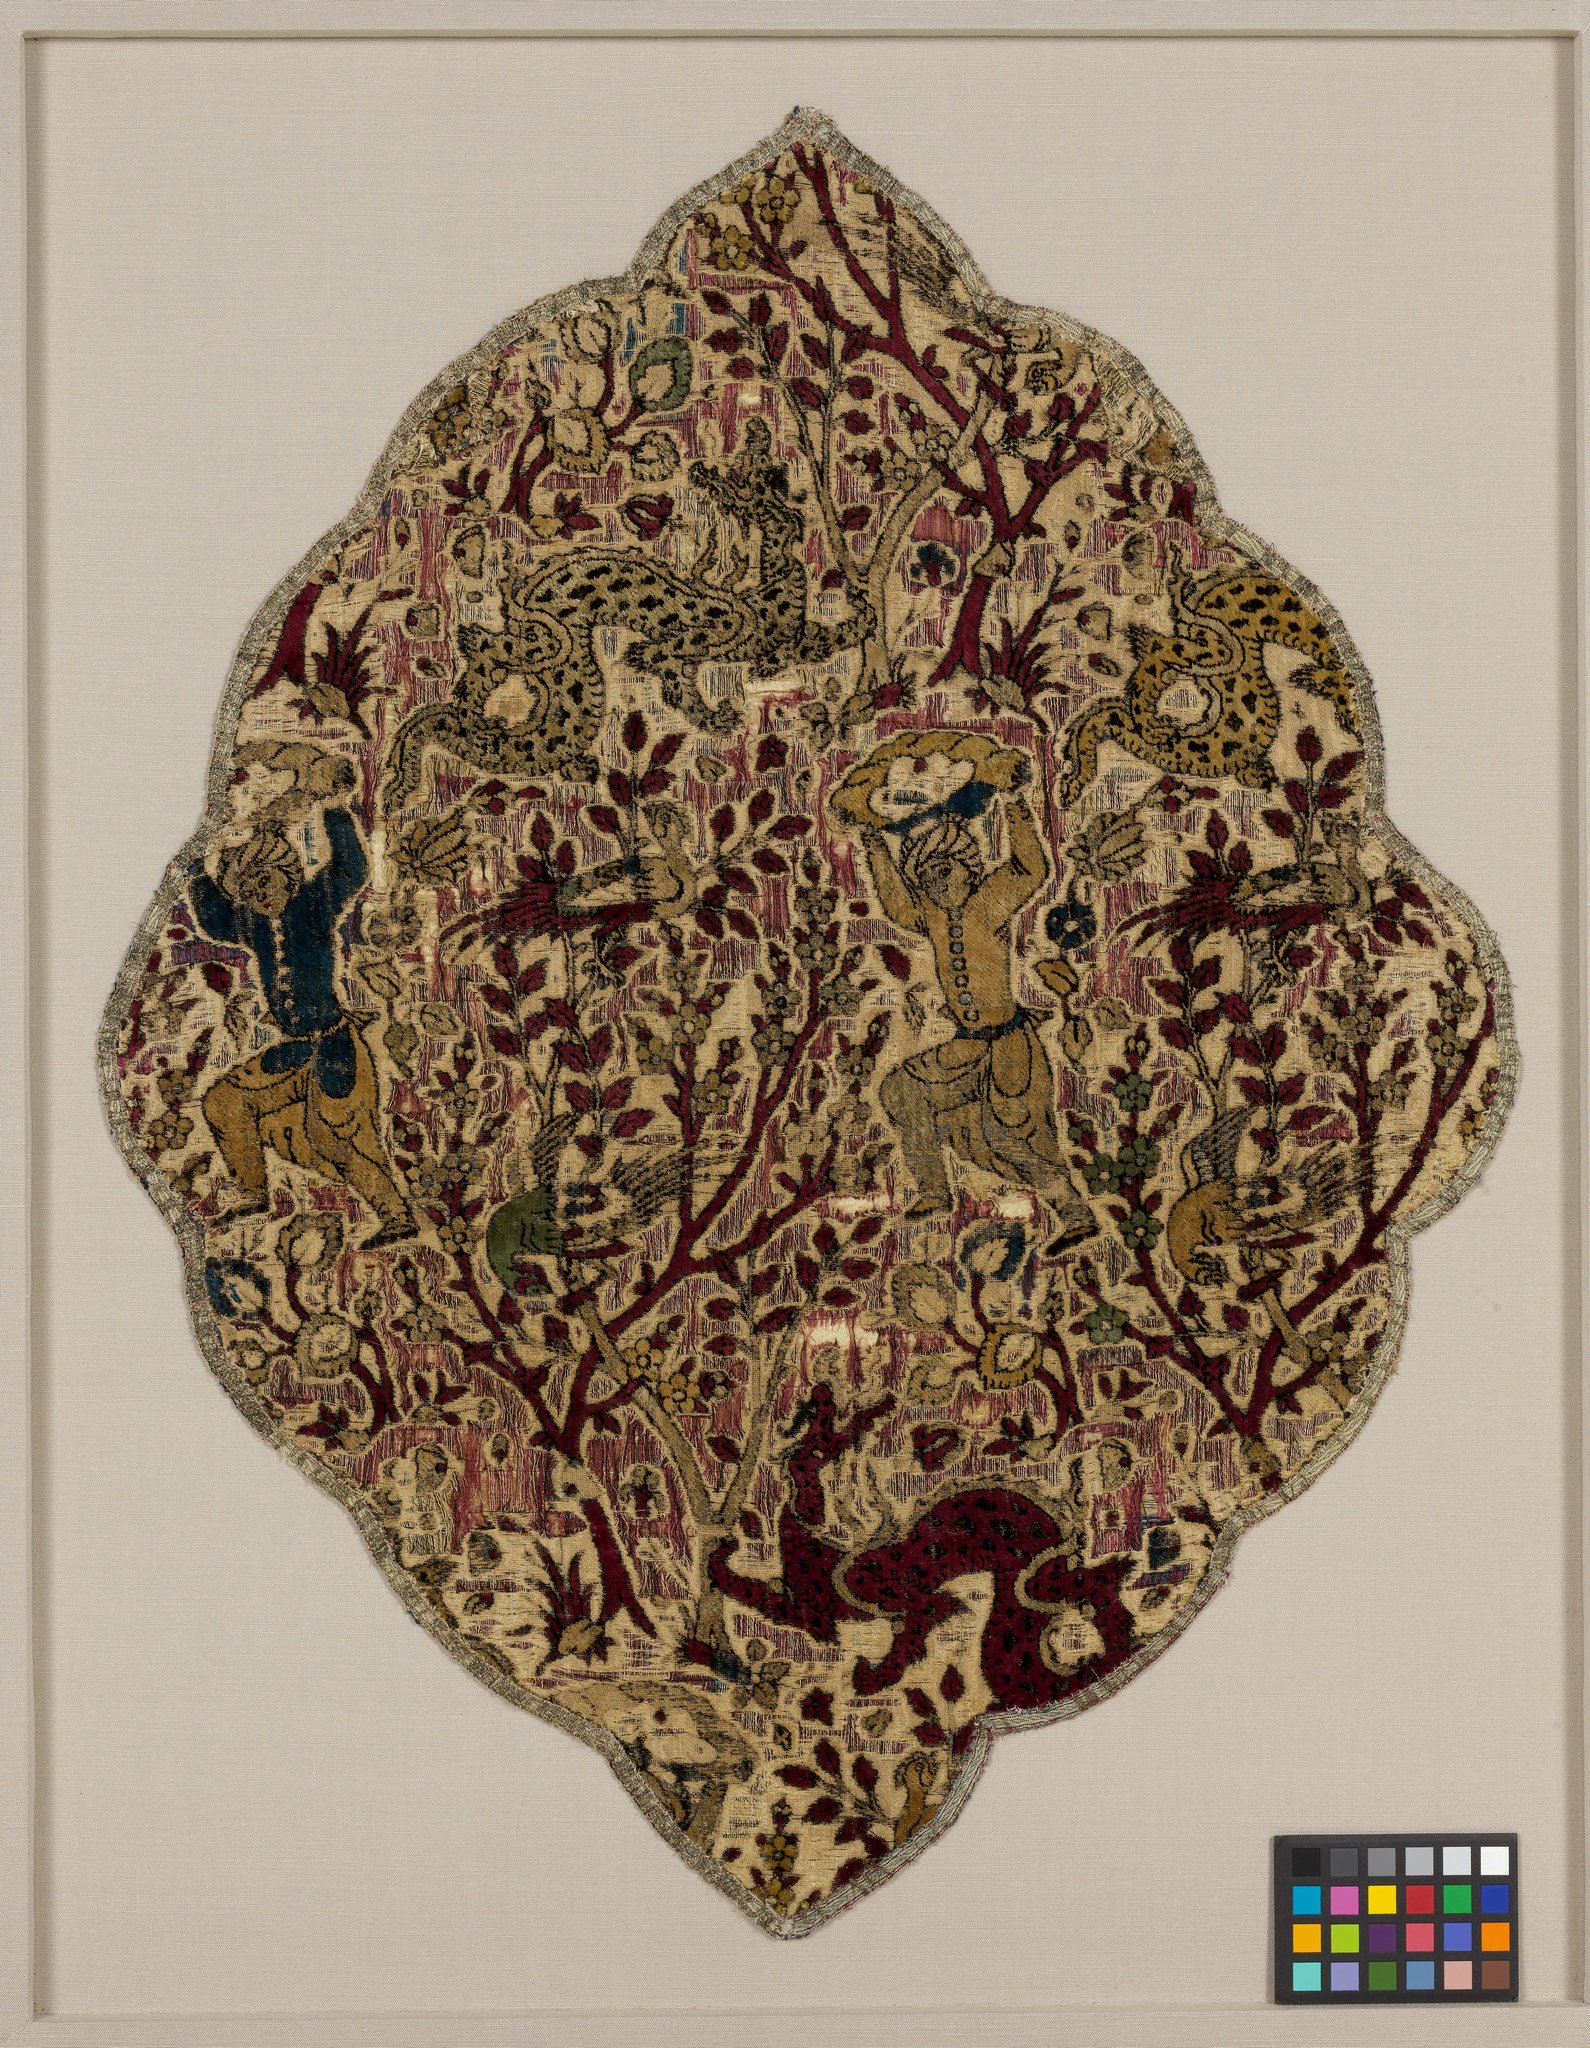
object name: fragment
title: Textile Fragment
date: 1540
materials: metal thread, silk, velvet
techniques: cutting, voiding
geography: iran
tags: birds,men,dragons